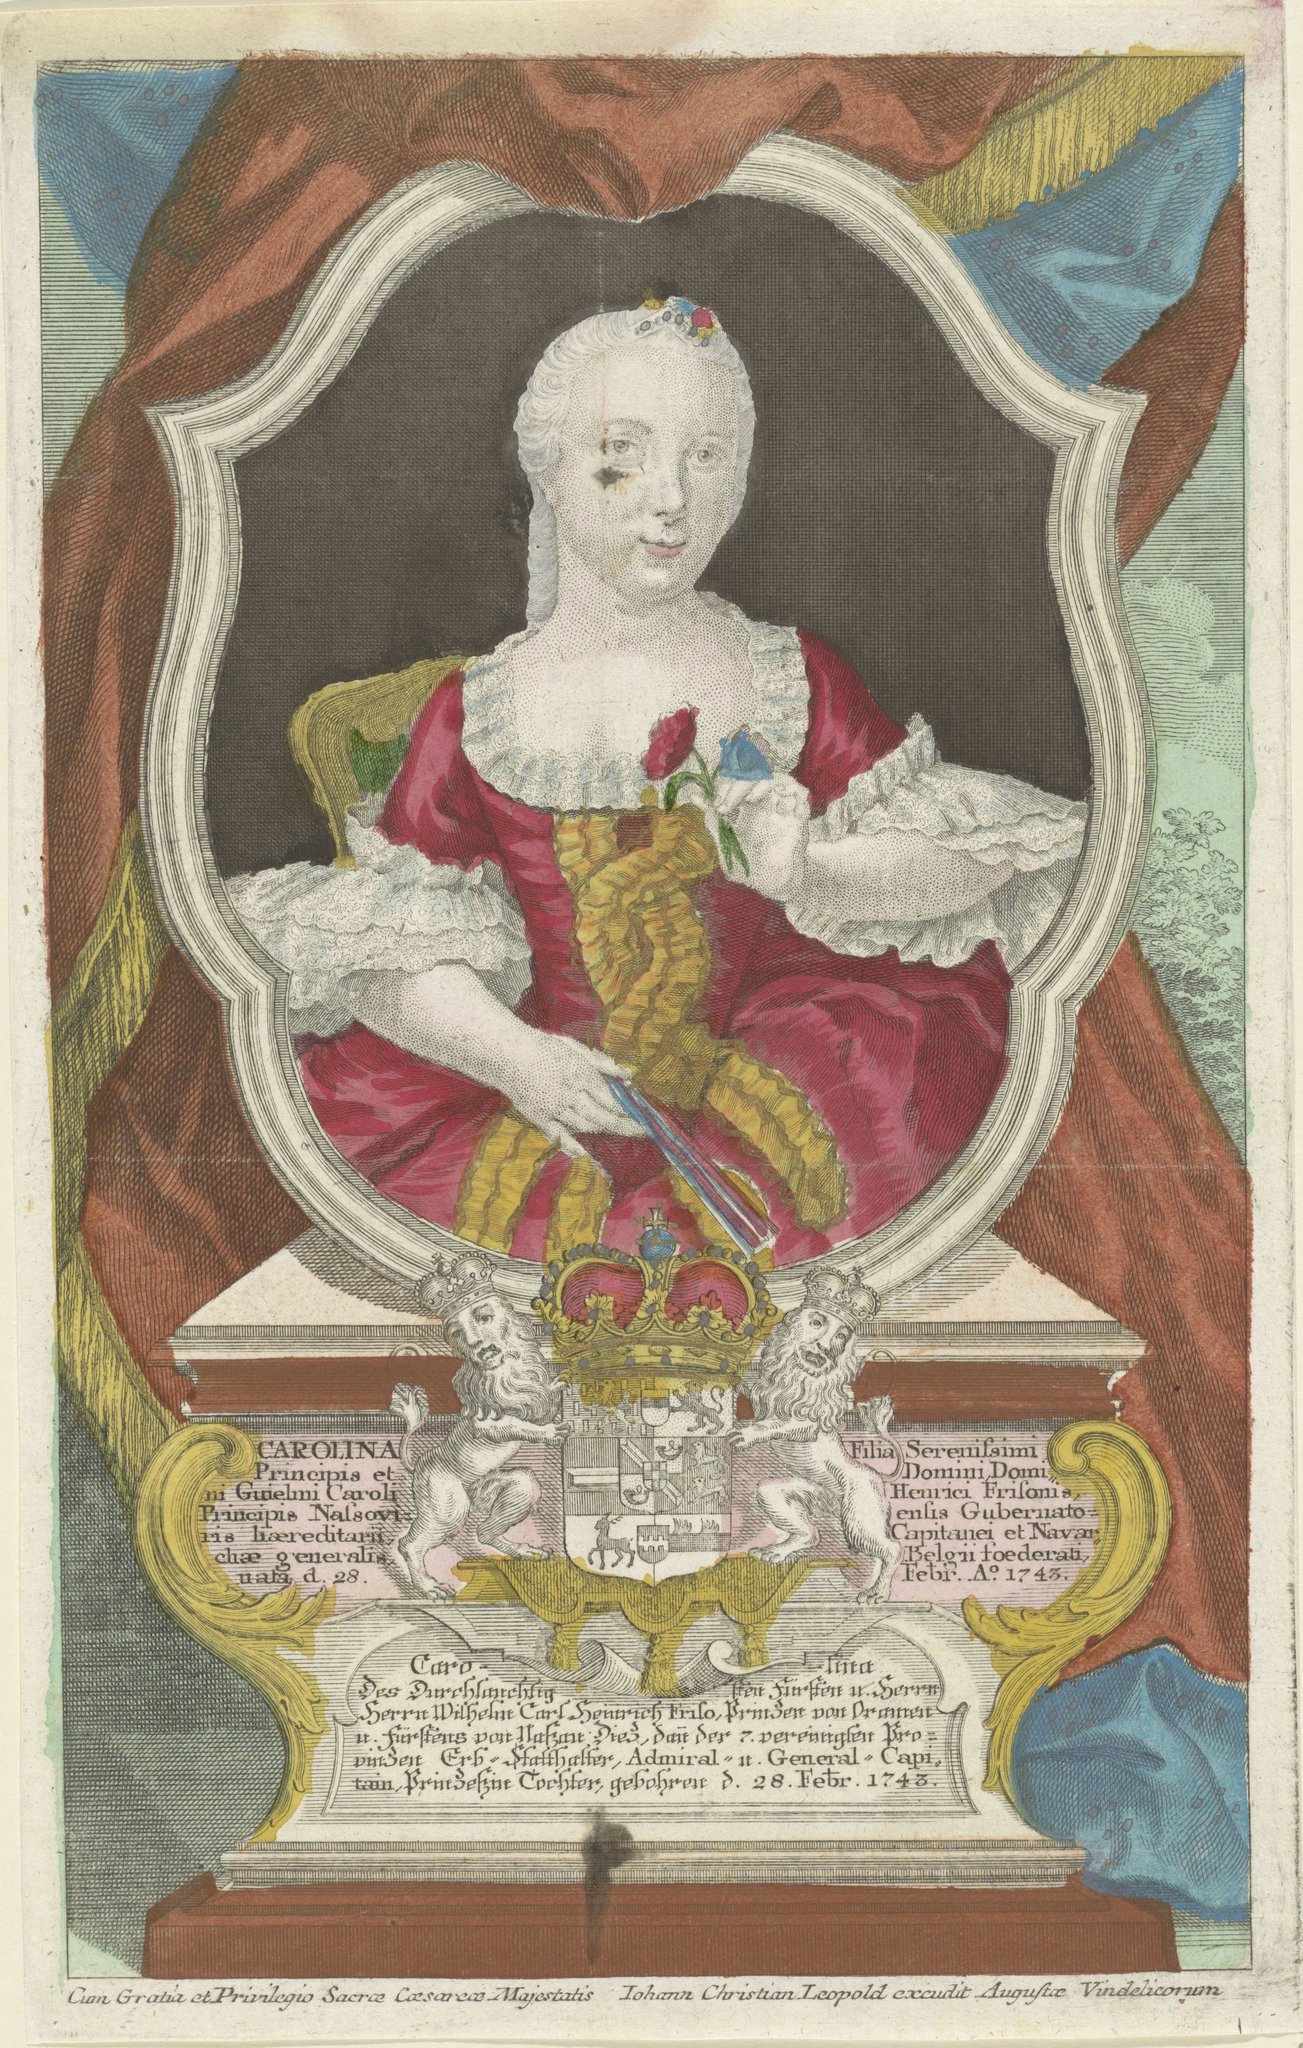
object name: print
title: Portret van Carolina, prinses van Oranje-Nassau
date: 1750-1755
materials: paper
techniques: engraving, etching, hand coloring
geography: augsburg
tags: carolina (prinses van oranje-nassau)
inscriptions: collector's mark: Lugt 2228, collector's mark: Lugt 2760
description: Portret van Carolina in een geornamenteerde omlijsting. In haar linkerhand een roos. Midden onder haar wapen met een kroon en twee leeuwen. Op een voetstuk zeven regels Latijnse en zes regels Duitse tekst.